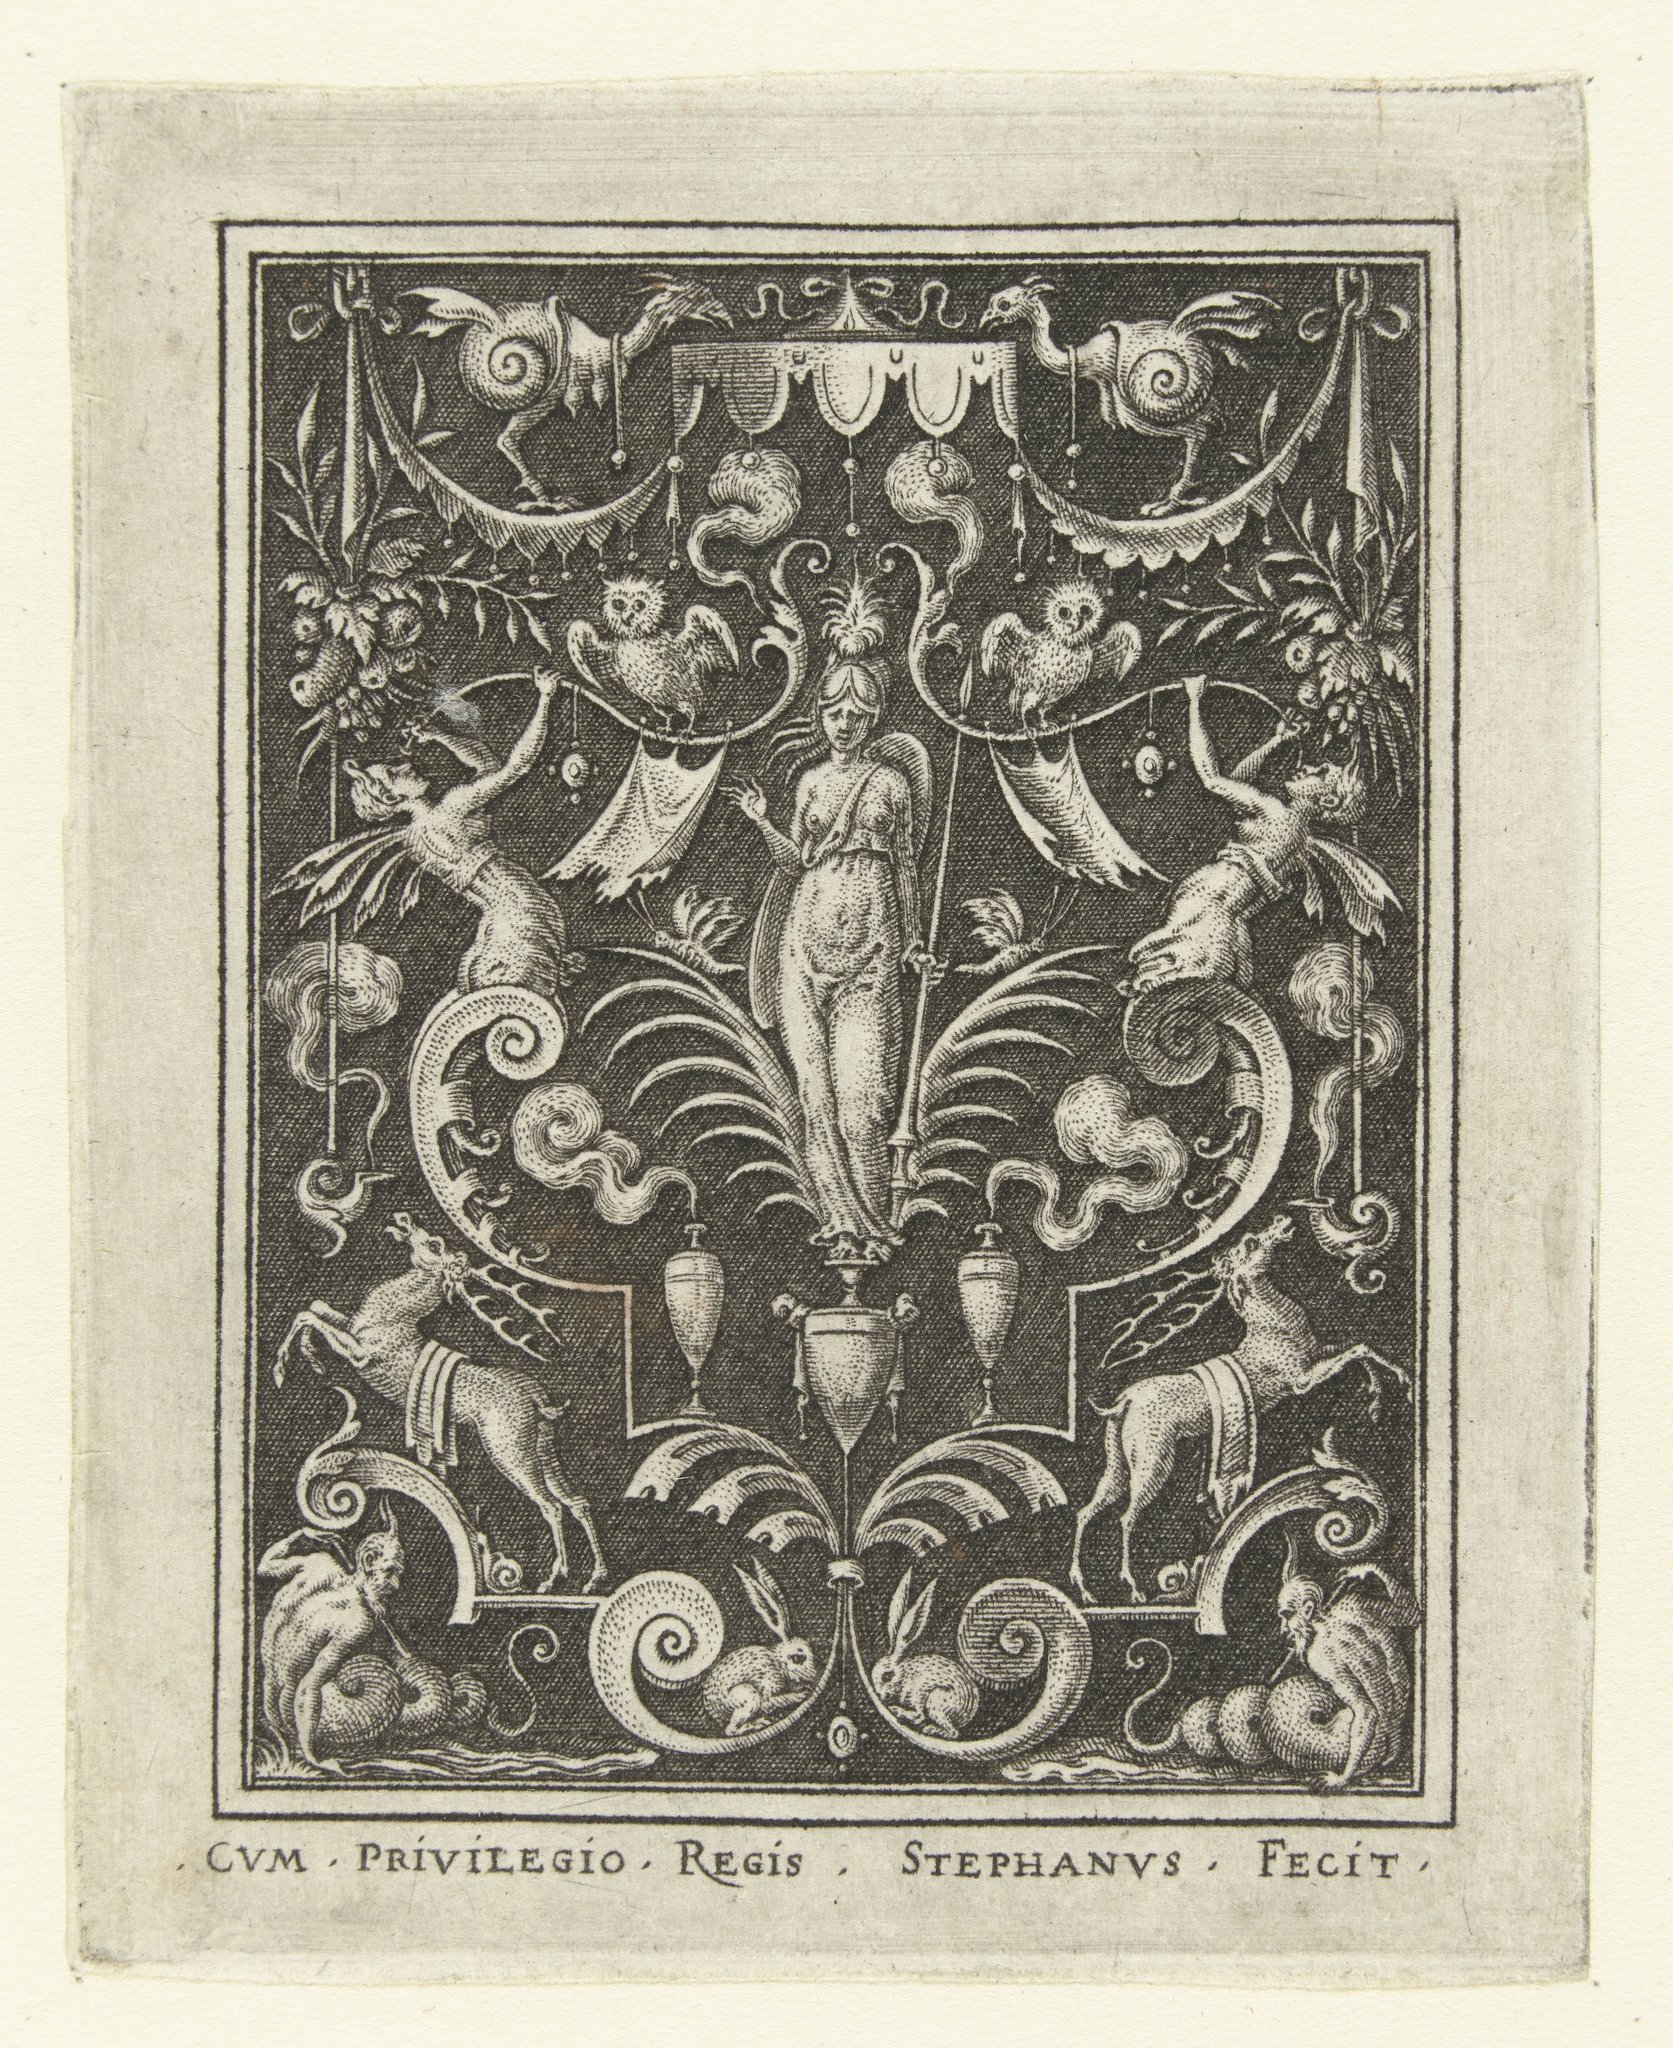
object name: print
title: Vlakdecoraties met godenfiguren in een omlijsting van grotesken (latere versie)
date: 1528-1583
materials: paper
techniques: engraving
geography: france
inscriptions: collector's mark: Lugt 240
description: Bellona, staande op een vaas met een lans in haar hand. Uit serie van 6 bladen.